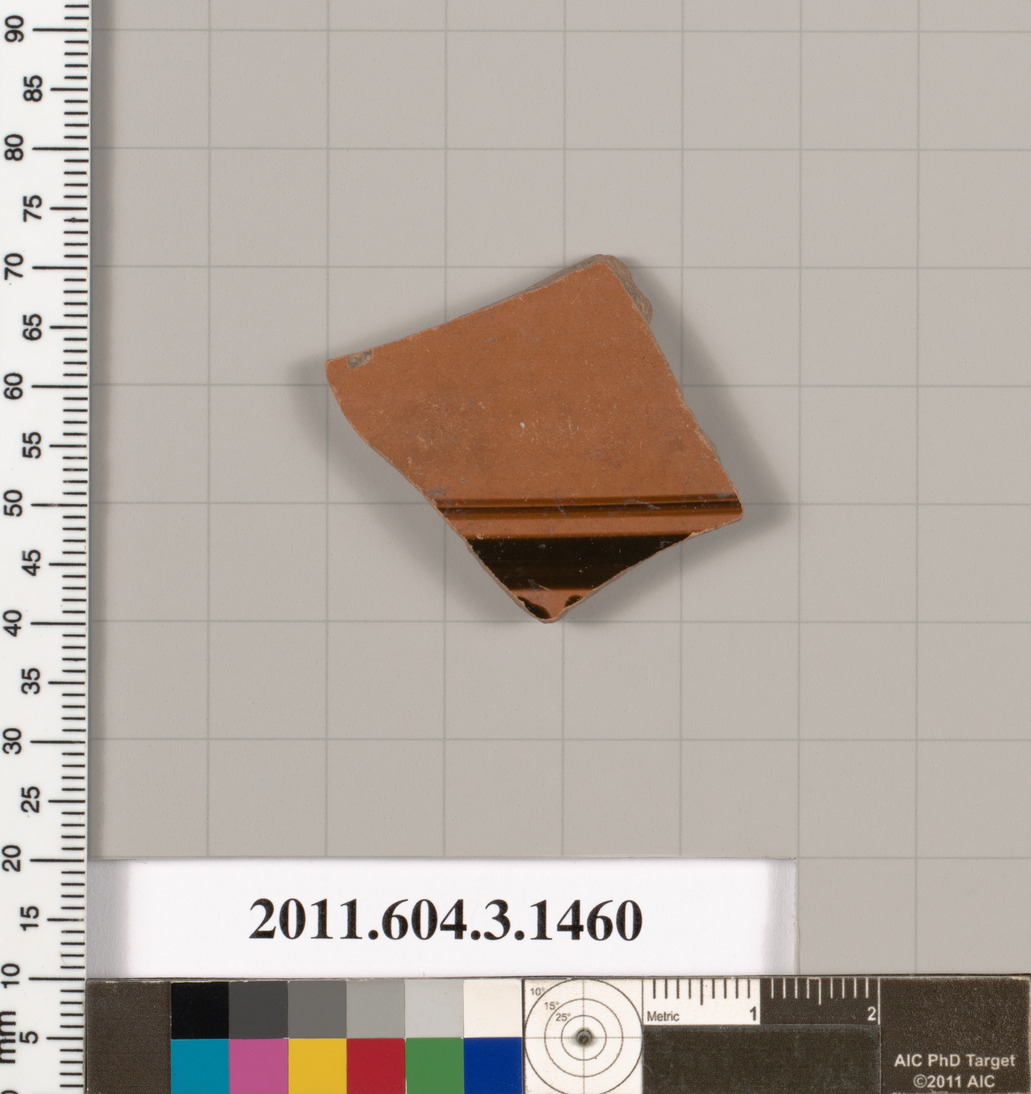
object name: skyphos fragment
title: Terracotta fragment of a skyphos (deep drinking cup)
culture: greek, attic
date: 600-401 BCE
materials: terracotta